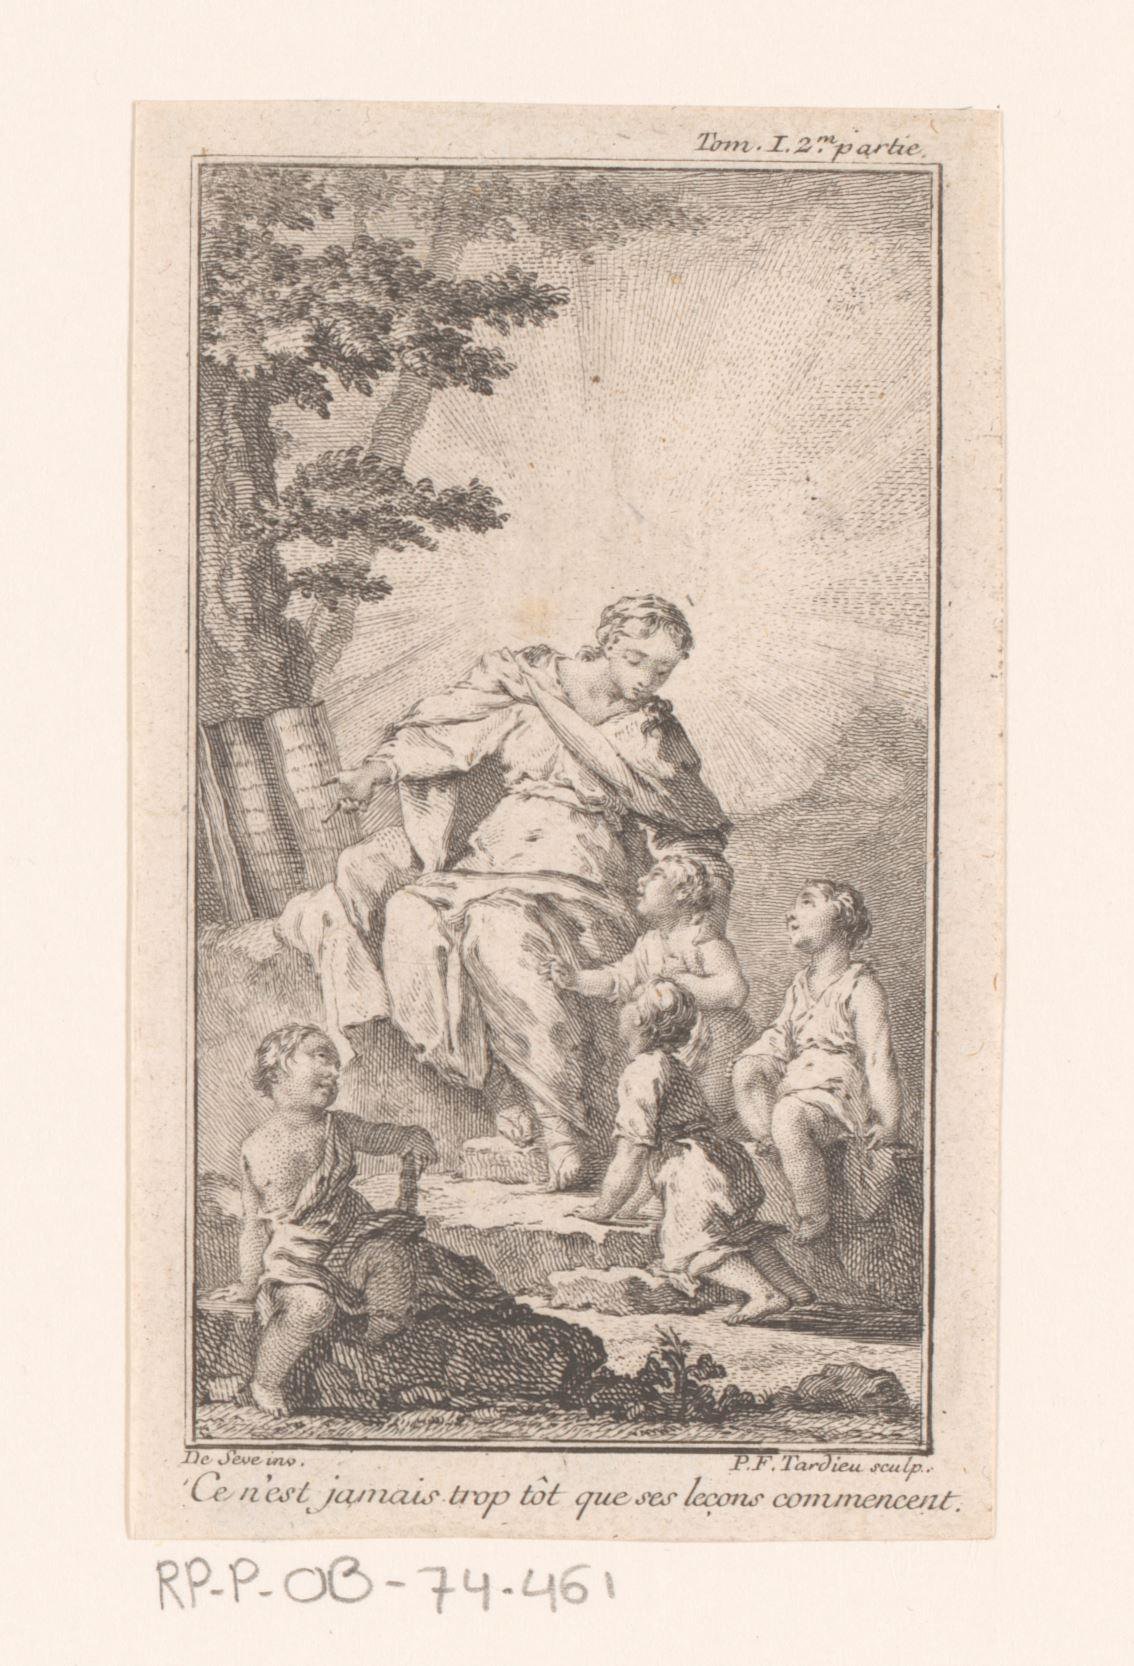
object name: book illustration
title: Ce n'est jamais trop tôt que ses leçons commencent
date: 1721-1771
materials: paper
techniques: engraving, etching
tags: education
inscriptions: collector's mark: Lugt 2228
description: In een rotsachtig landschap wijst een vrouw vier kinderen op een boek, allen gekleed in klassieke gewaden.